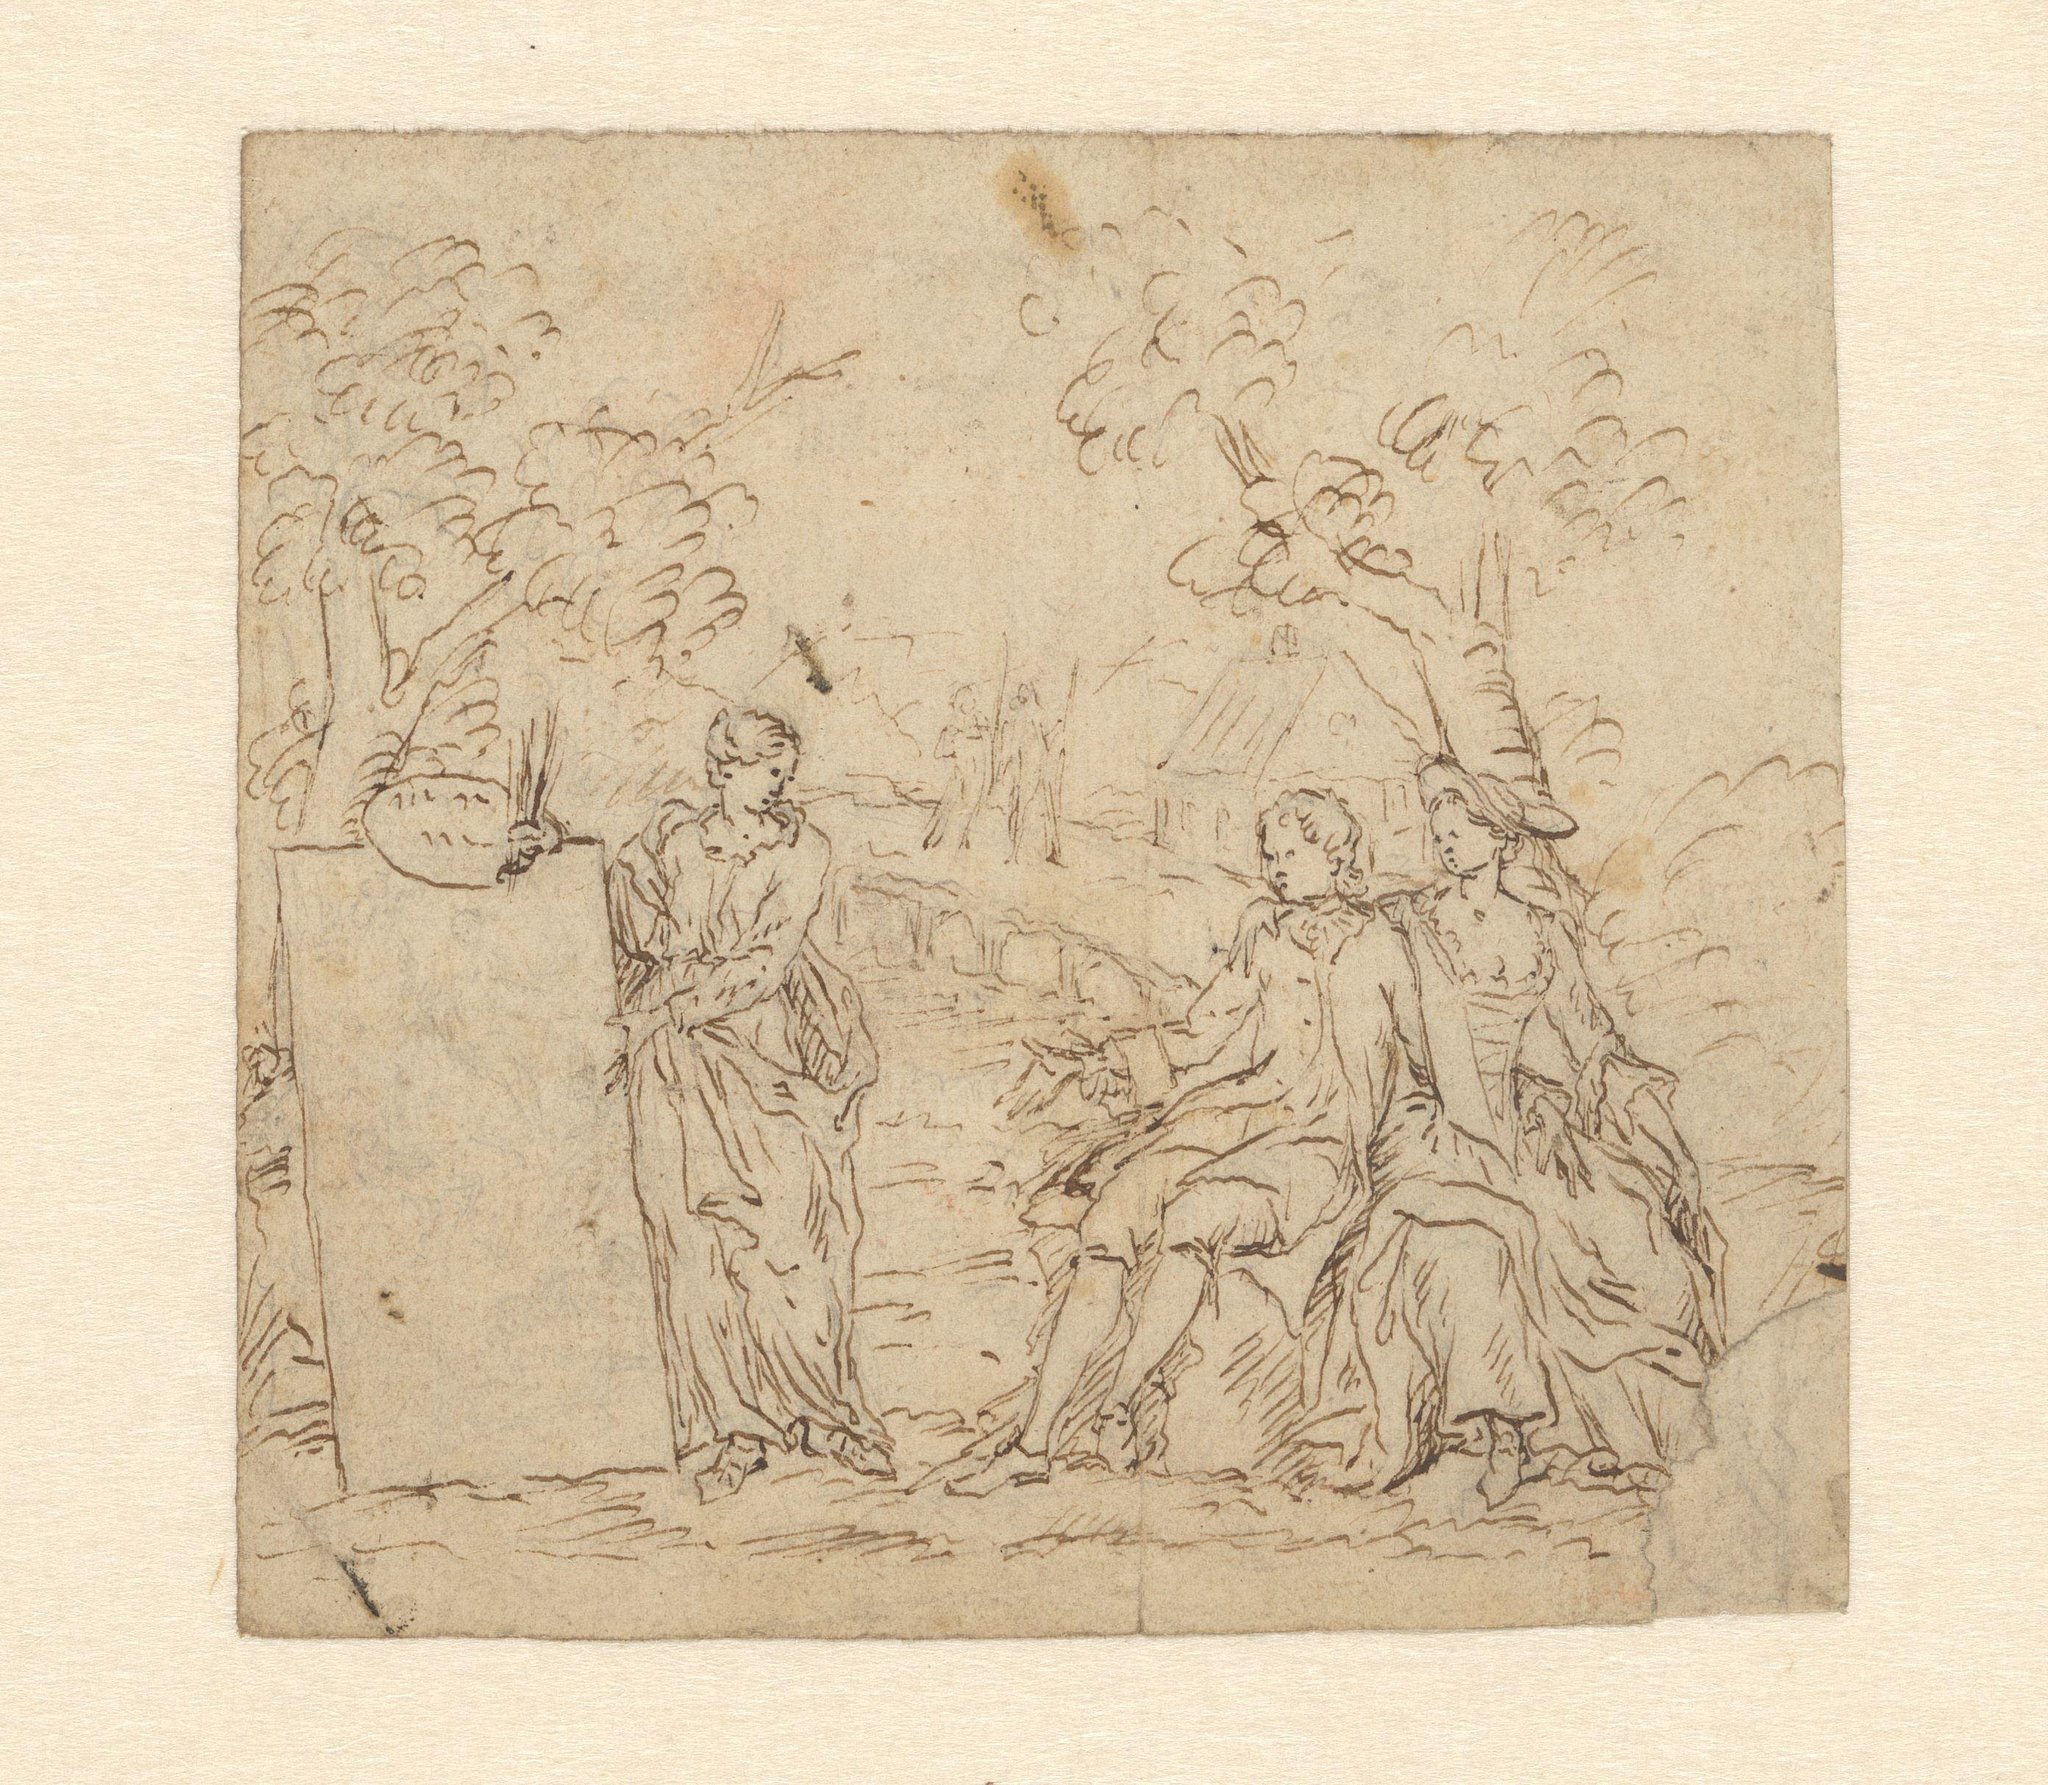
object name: drawing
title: Landschap met Pictura en zittend paar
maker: Anonymous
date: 1700-1800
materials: ink, paper, pencil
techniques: pen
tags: 'pictura', symbolic representations, allegories and emblems ~ painting; 'pittura' (ripa)